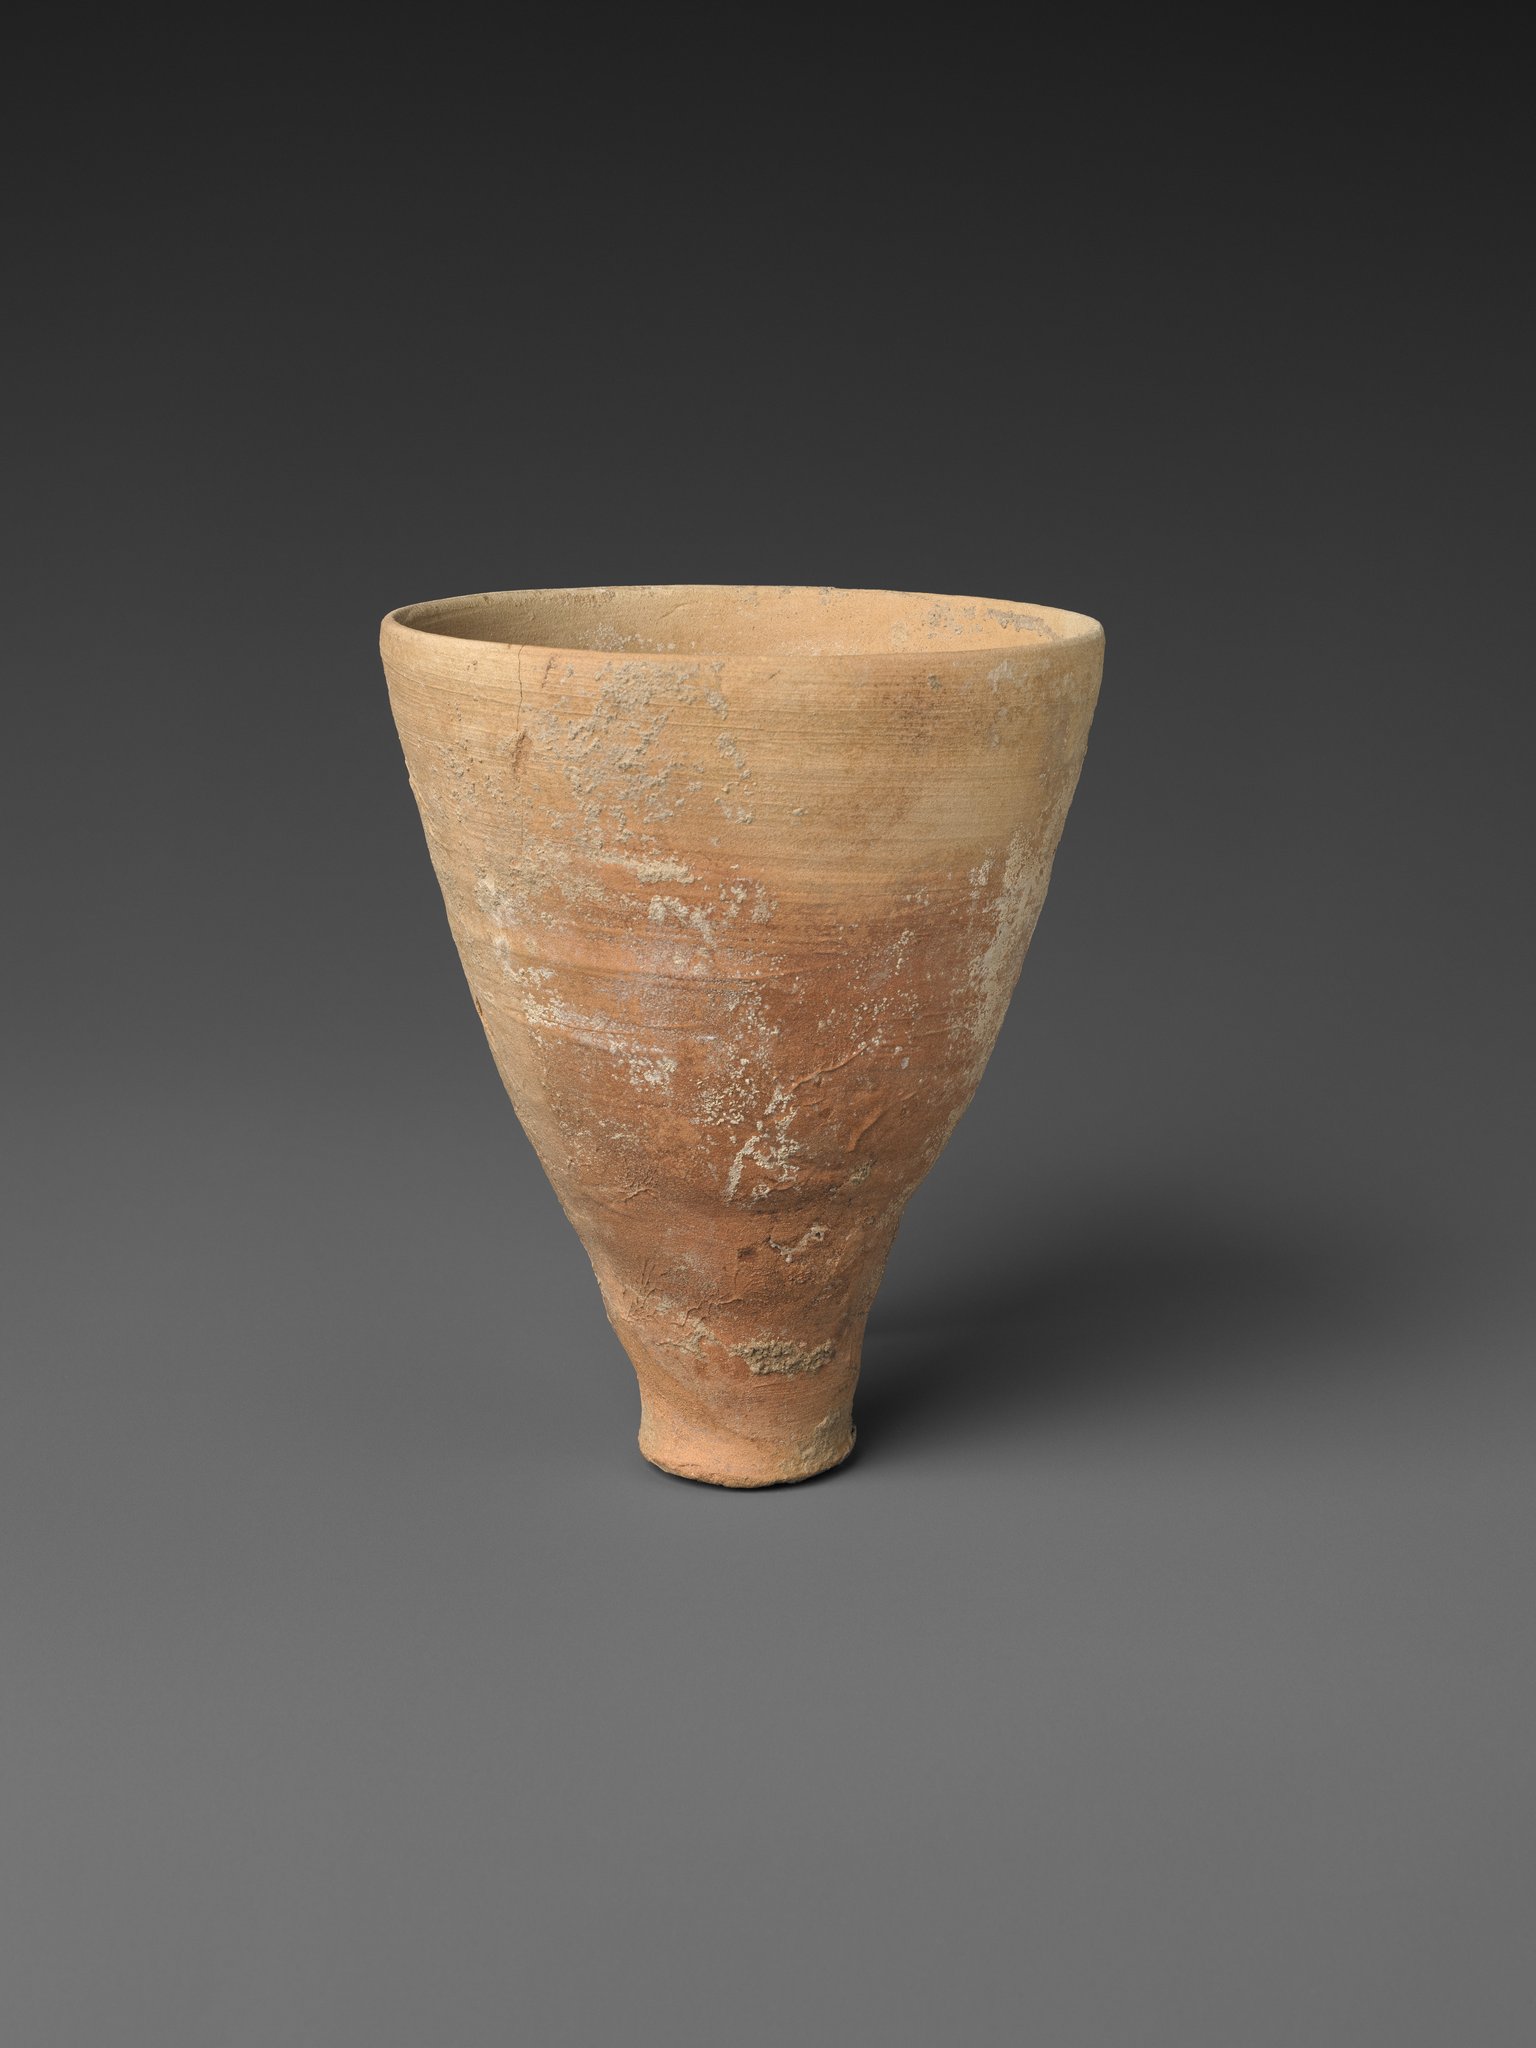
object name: cup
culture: sumerian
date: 2600-2500 BCE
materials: ceramic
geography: mesopotamia